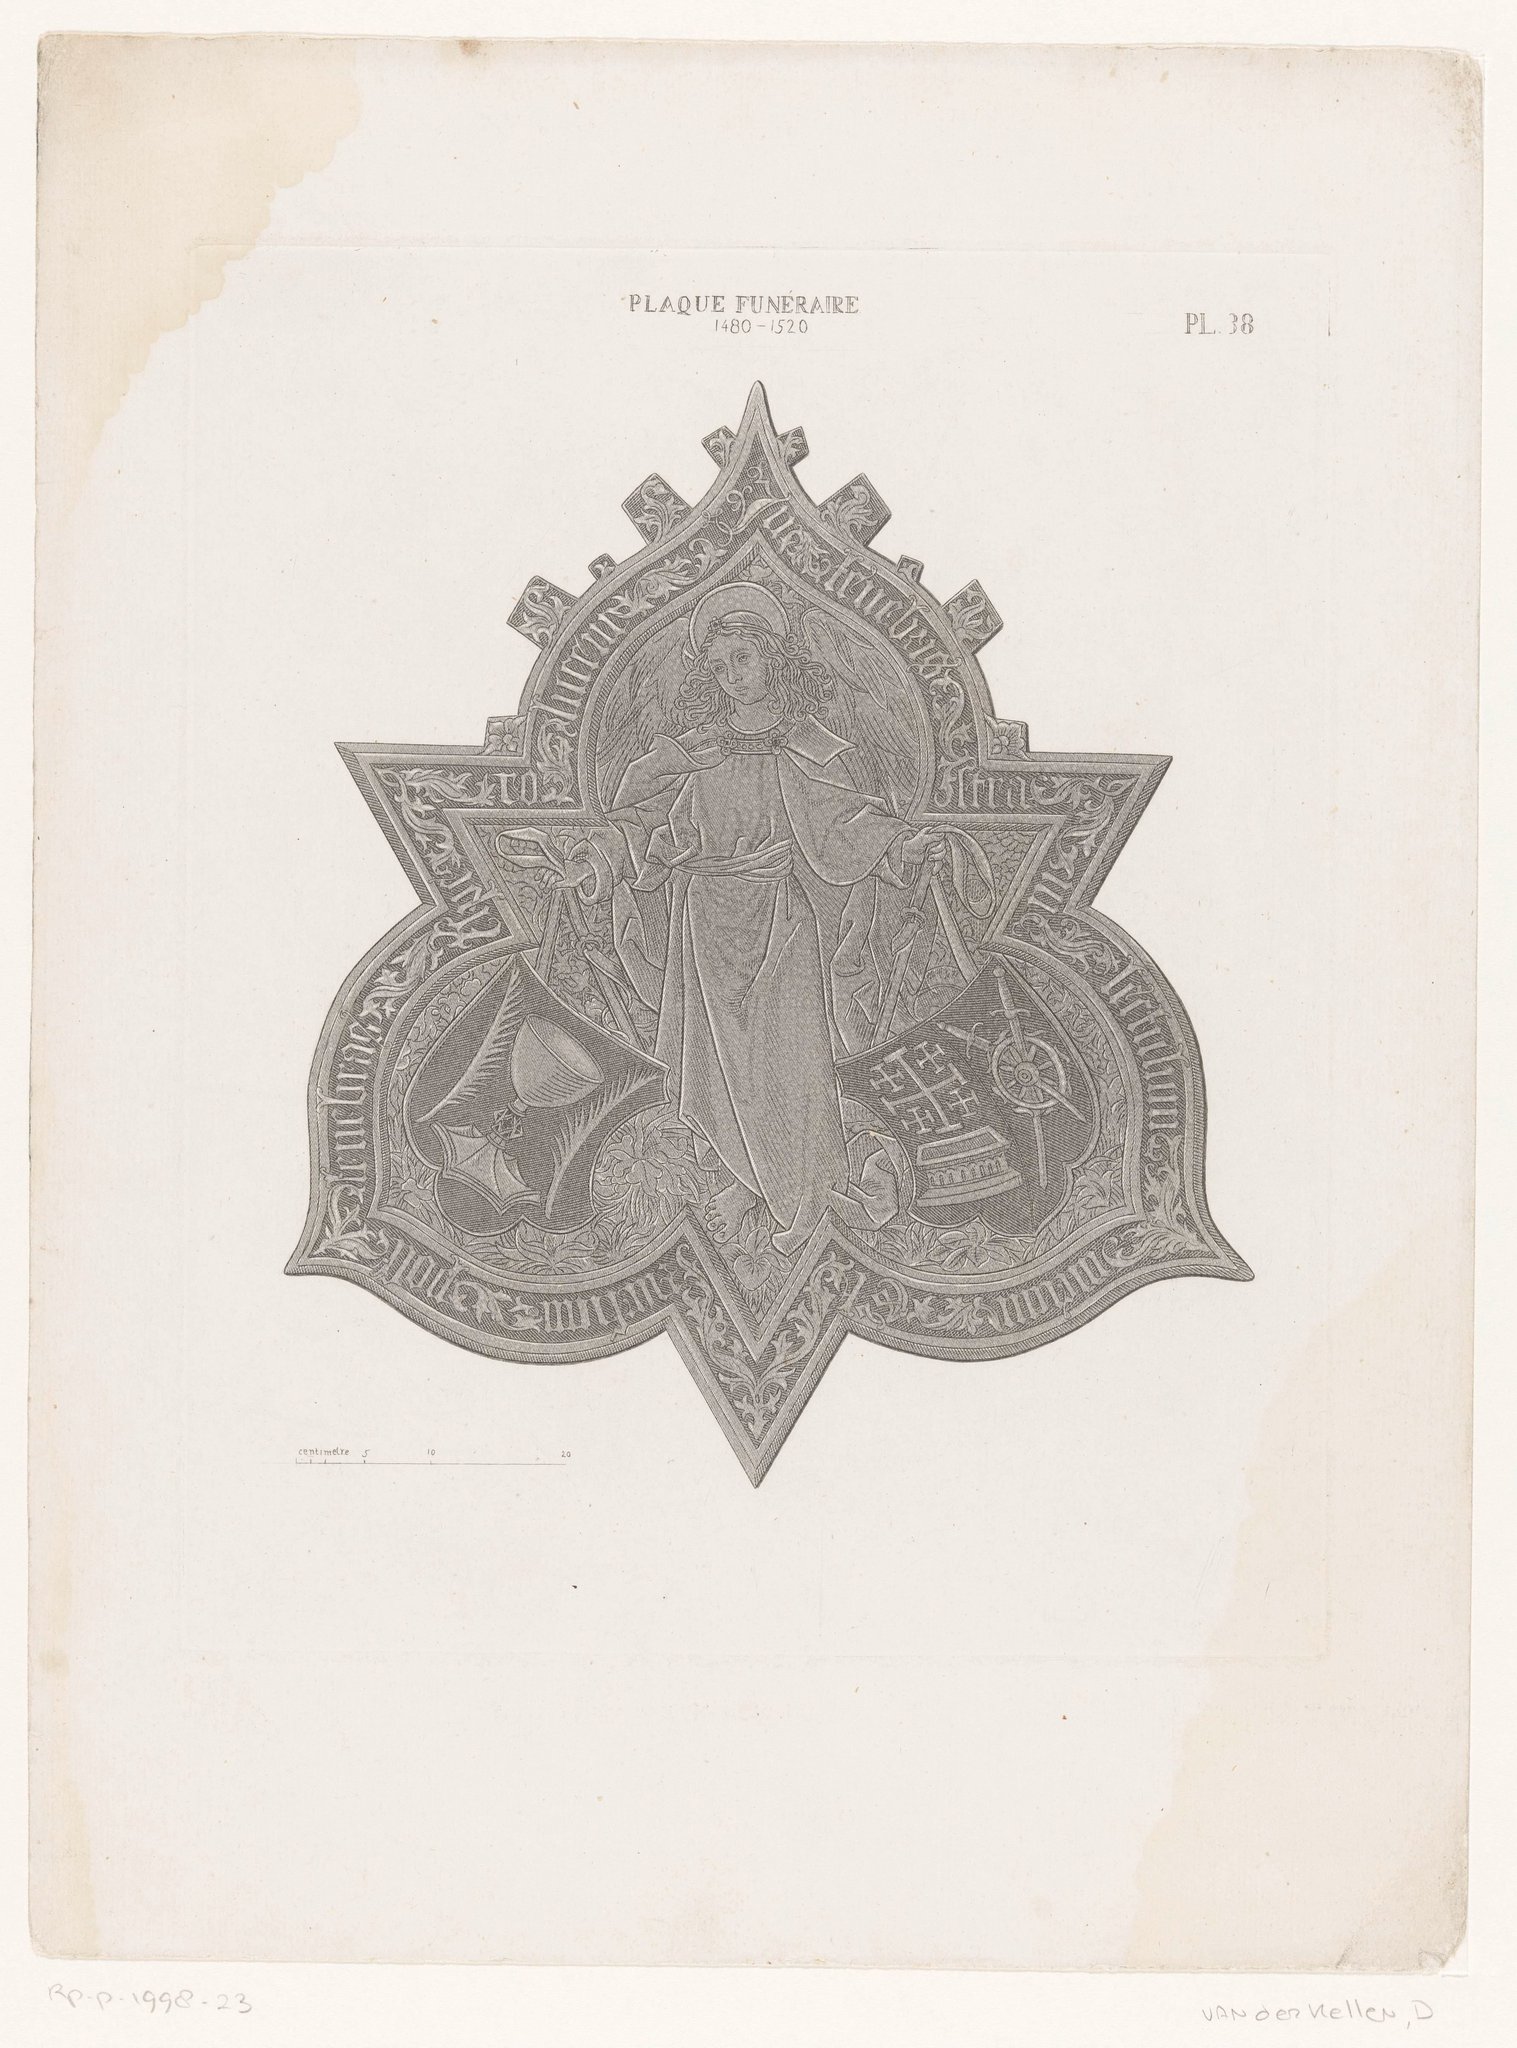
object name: book illustration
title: Plaat van grafzerk Gijsbert Willemsz. Raet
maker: david van der kellen (1804-1879)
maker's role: die cutter, draughtsman, print maker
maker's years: 1804-1879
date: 1865-1878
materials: paper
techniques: etching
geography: netherlands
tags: gravestone, tombstone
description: Geelkoperen plaat van de grafzerk van Gijsbert Willemsz. Raet, priester aan de St. Johanneskerk te Gouda.